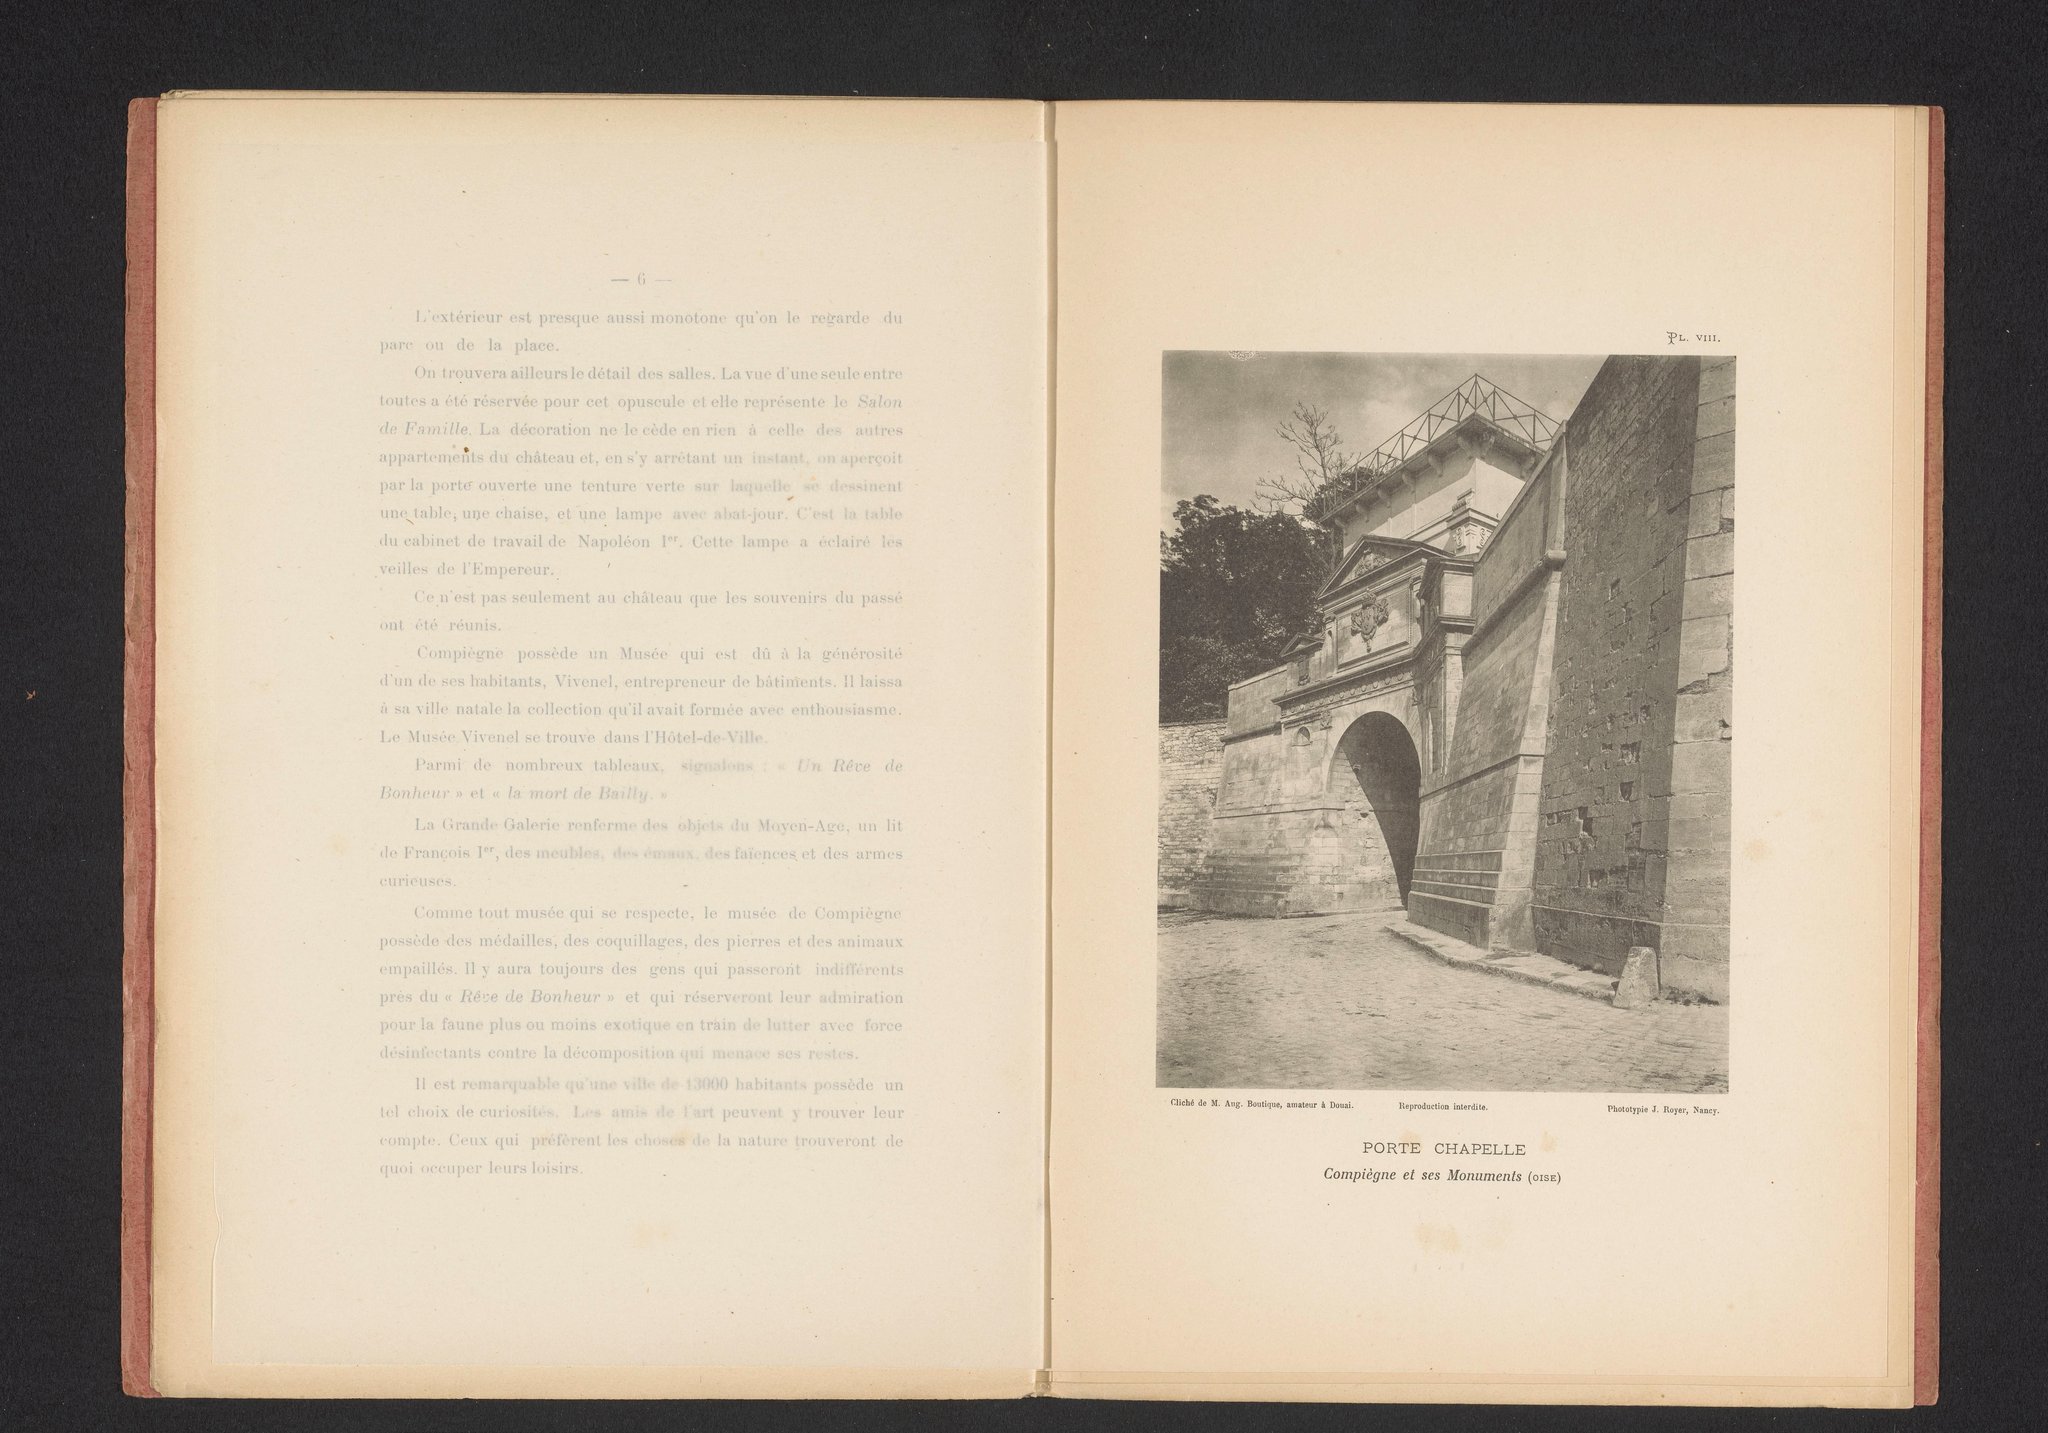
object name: photomechanical print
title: Compiègne et ses Monuments (oise)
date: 1890-1895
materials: paper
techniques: photograph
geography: douai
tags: church (exterior), door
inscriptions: number: ‘Pl. VIII.’, inscription: ‘Reproduction interdite.’